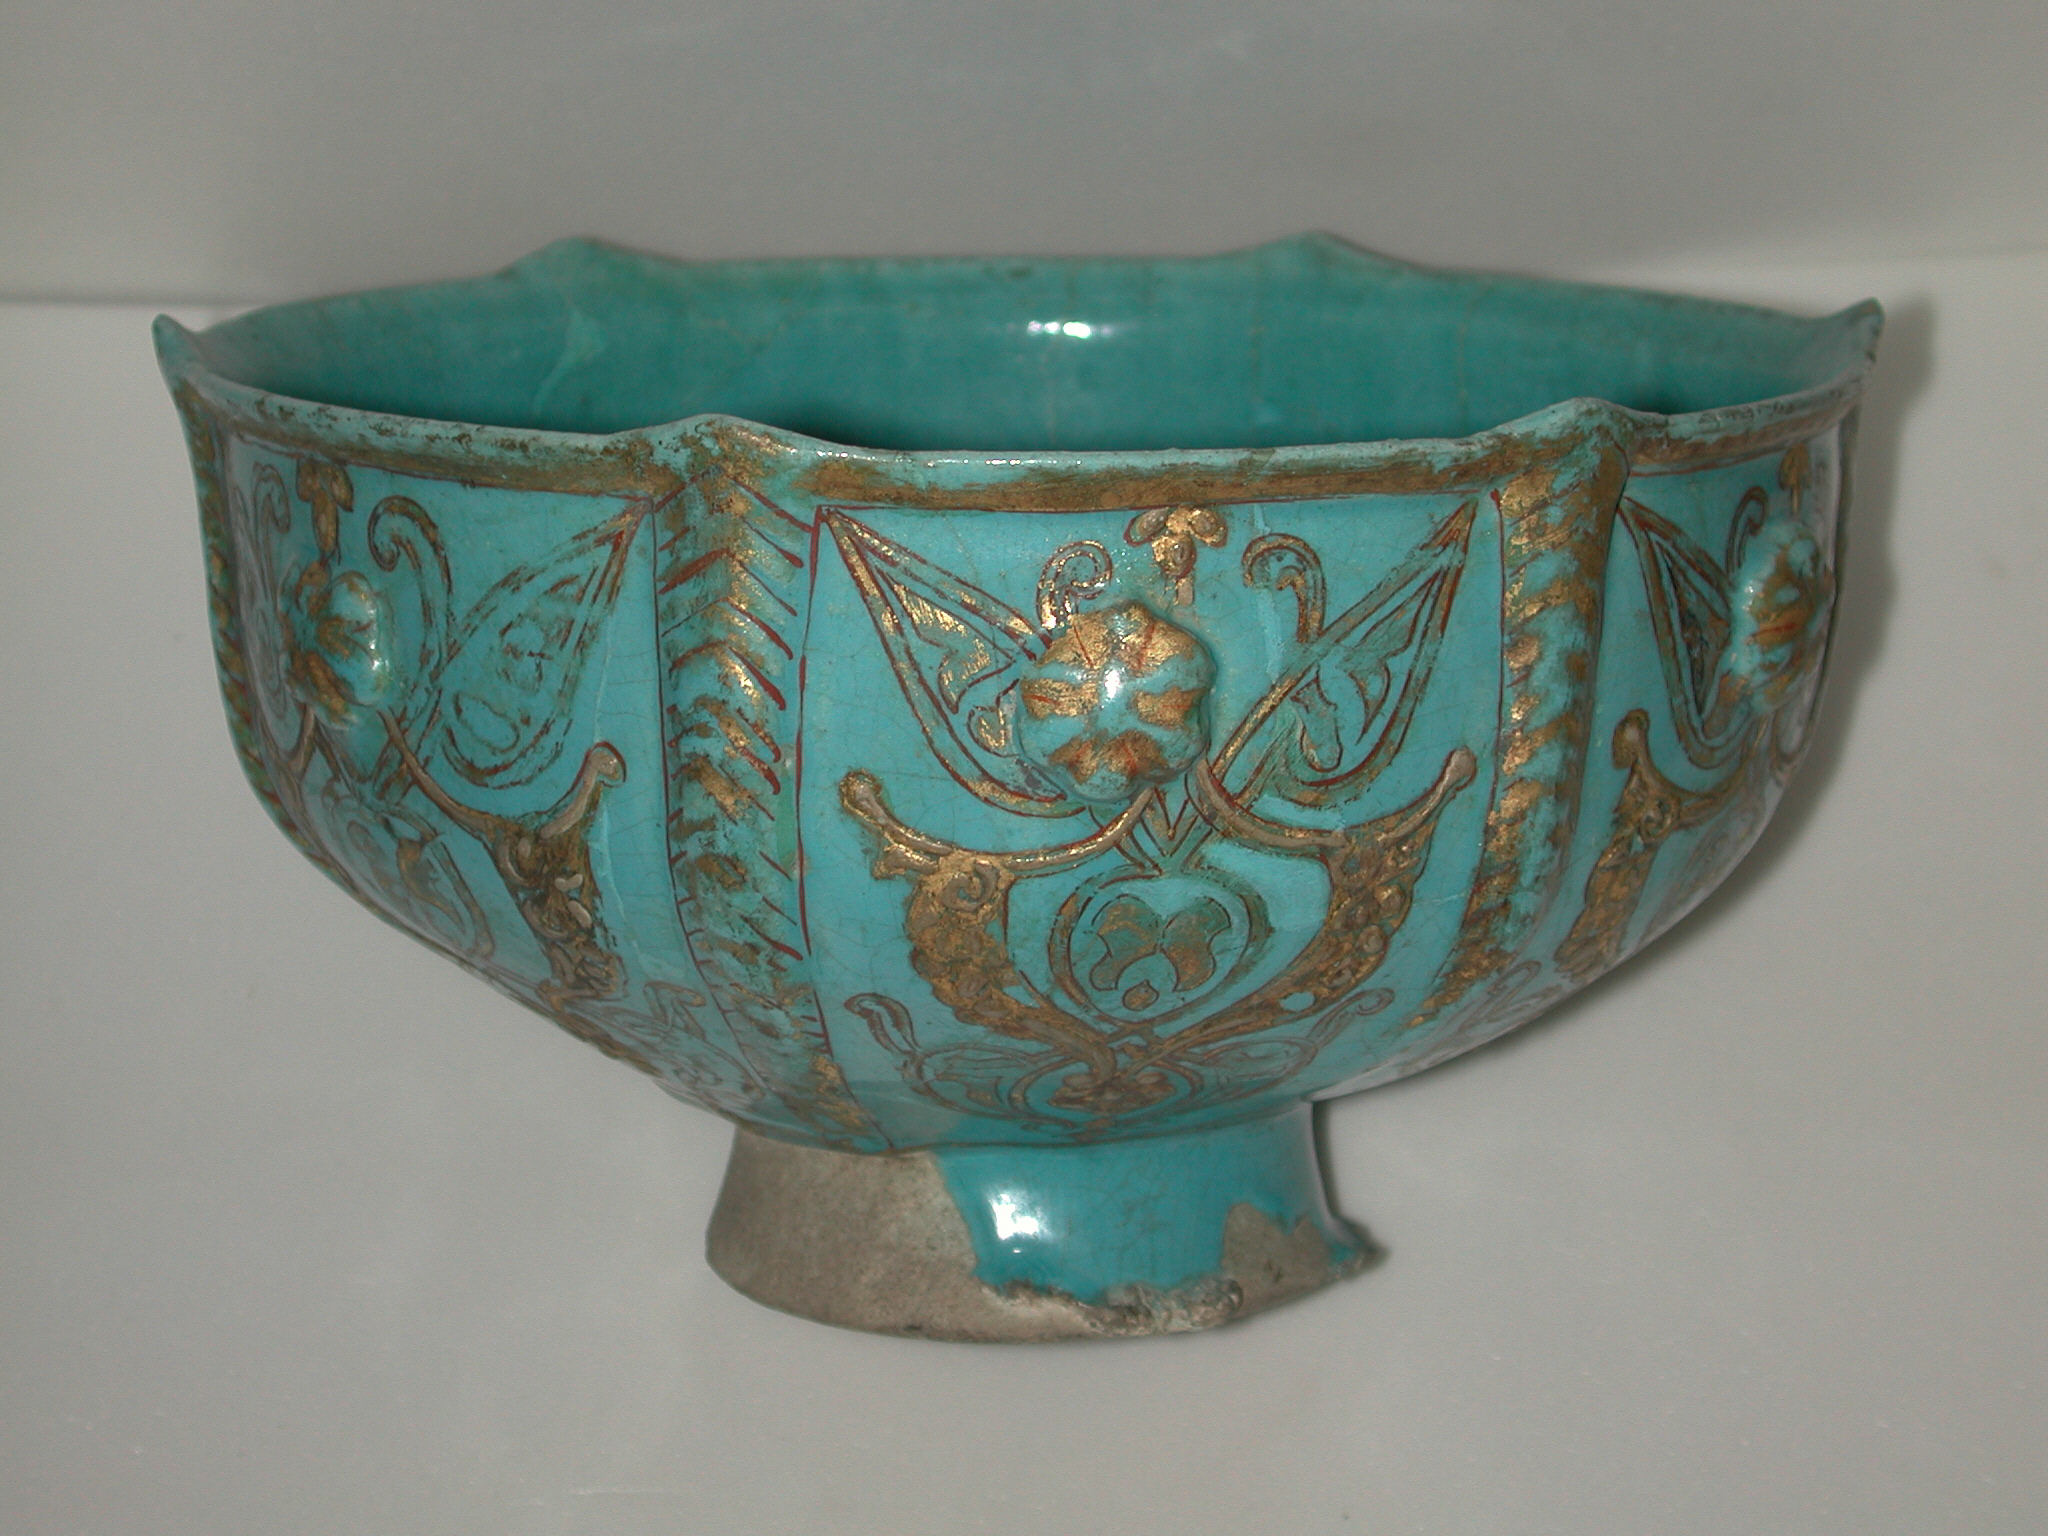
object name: bowl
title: Footed Bowl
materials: glaze, stonepaste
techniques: gilding, molding, overglaze, painting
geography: iran